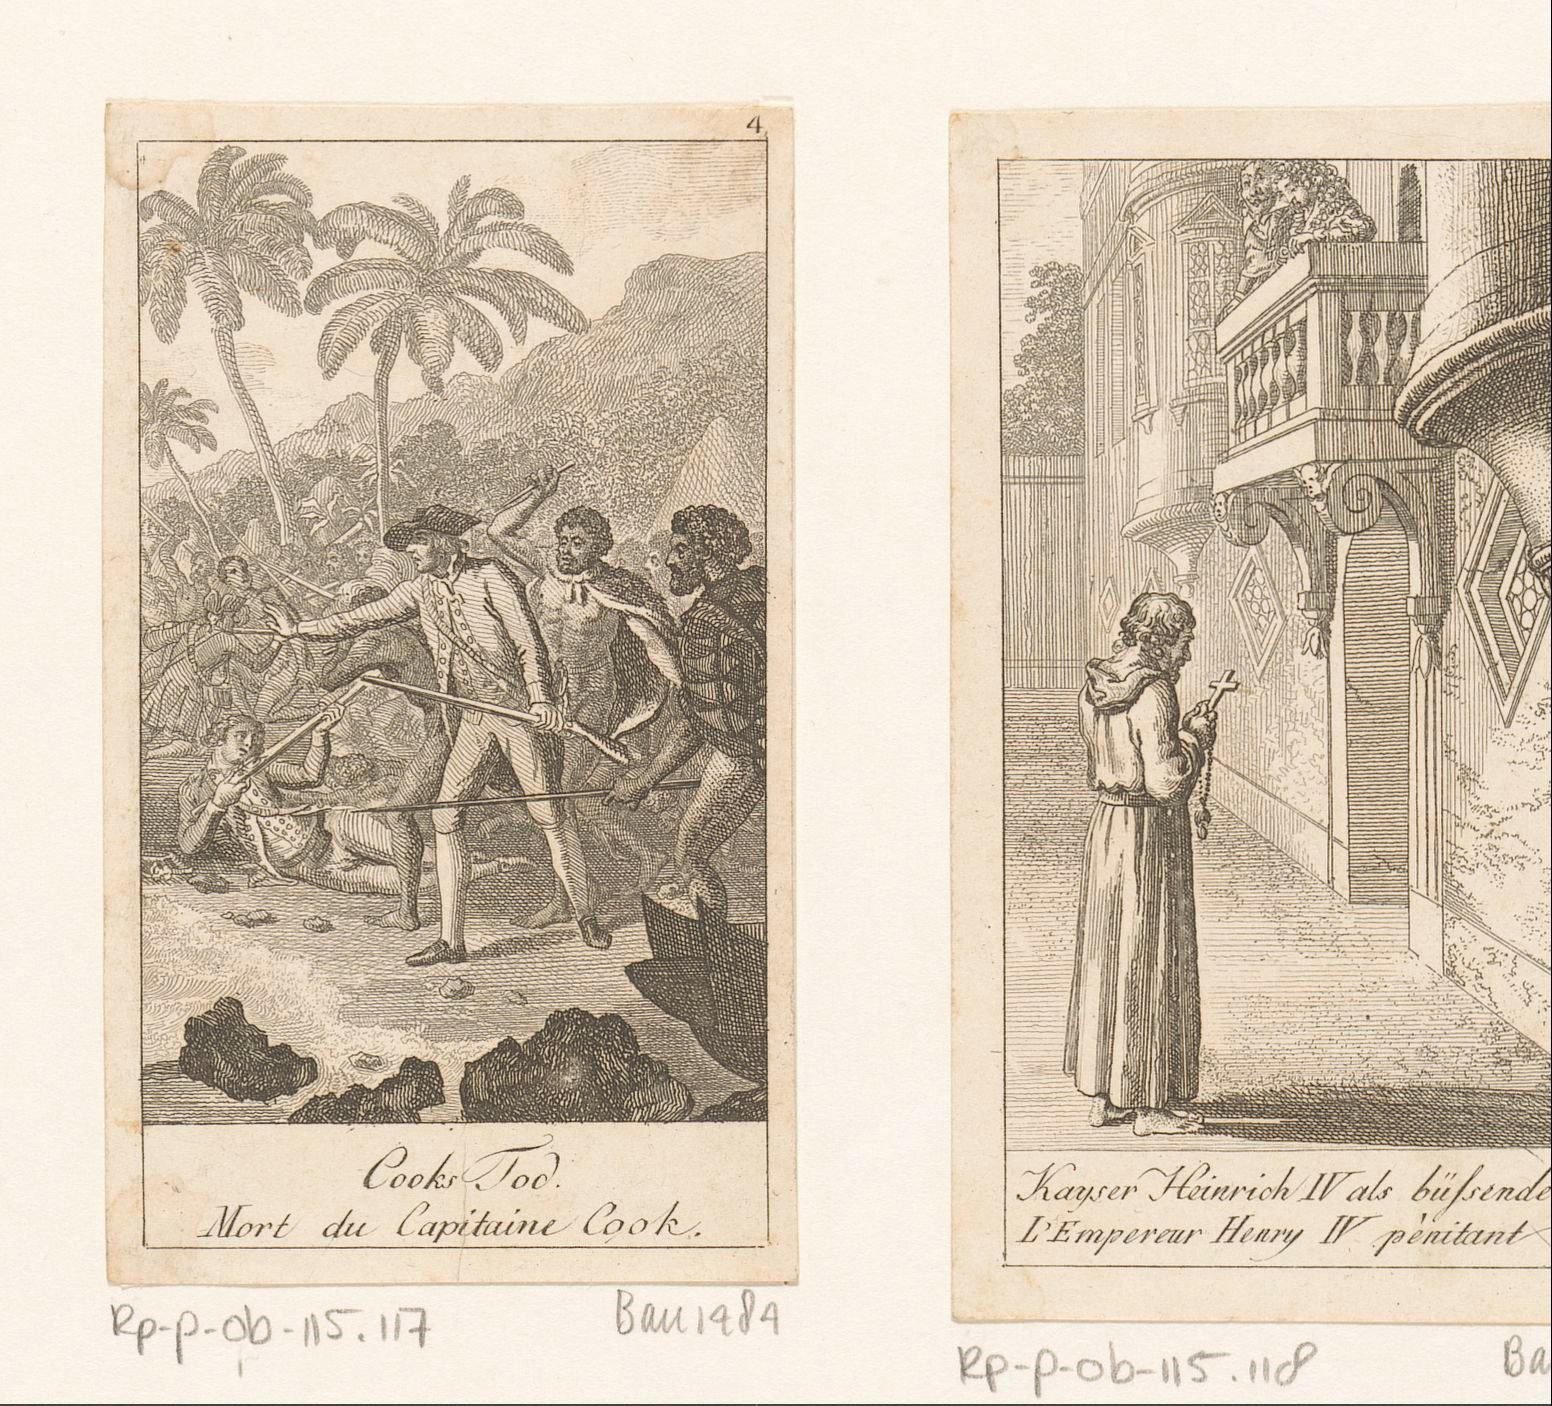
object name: print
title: James Cook arriveert op Hawaï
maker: daniel nikolaus chodowiecki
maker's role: draughtsman, print maker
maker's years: 1726-1801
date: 1790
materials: paper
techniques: etching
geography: berlin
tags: james cook, history, exploration, expedition, voyage of discovery, native peoples of the americas, trees: palm-tree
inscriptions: collector's mark: Lugt 2228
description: Prent gebruikt voor: Gothaischer Hof Kalender zum Nutzen und Vergnügen eingerichtet auf das Jahr 1791. Gotha: C. W. Ettinger, [1790].